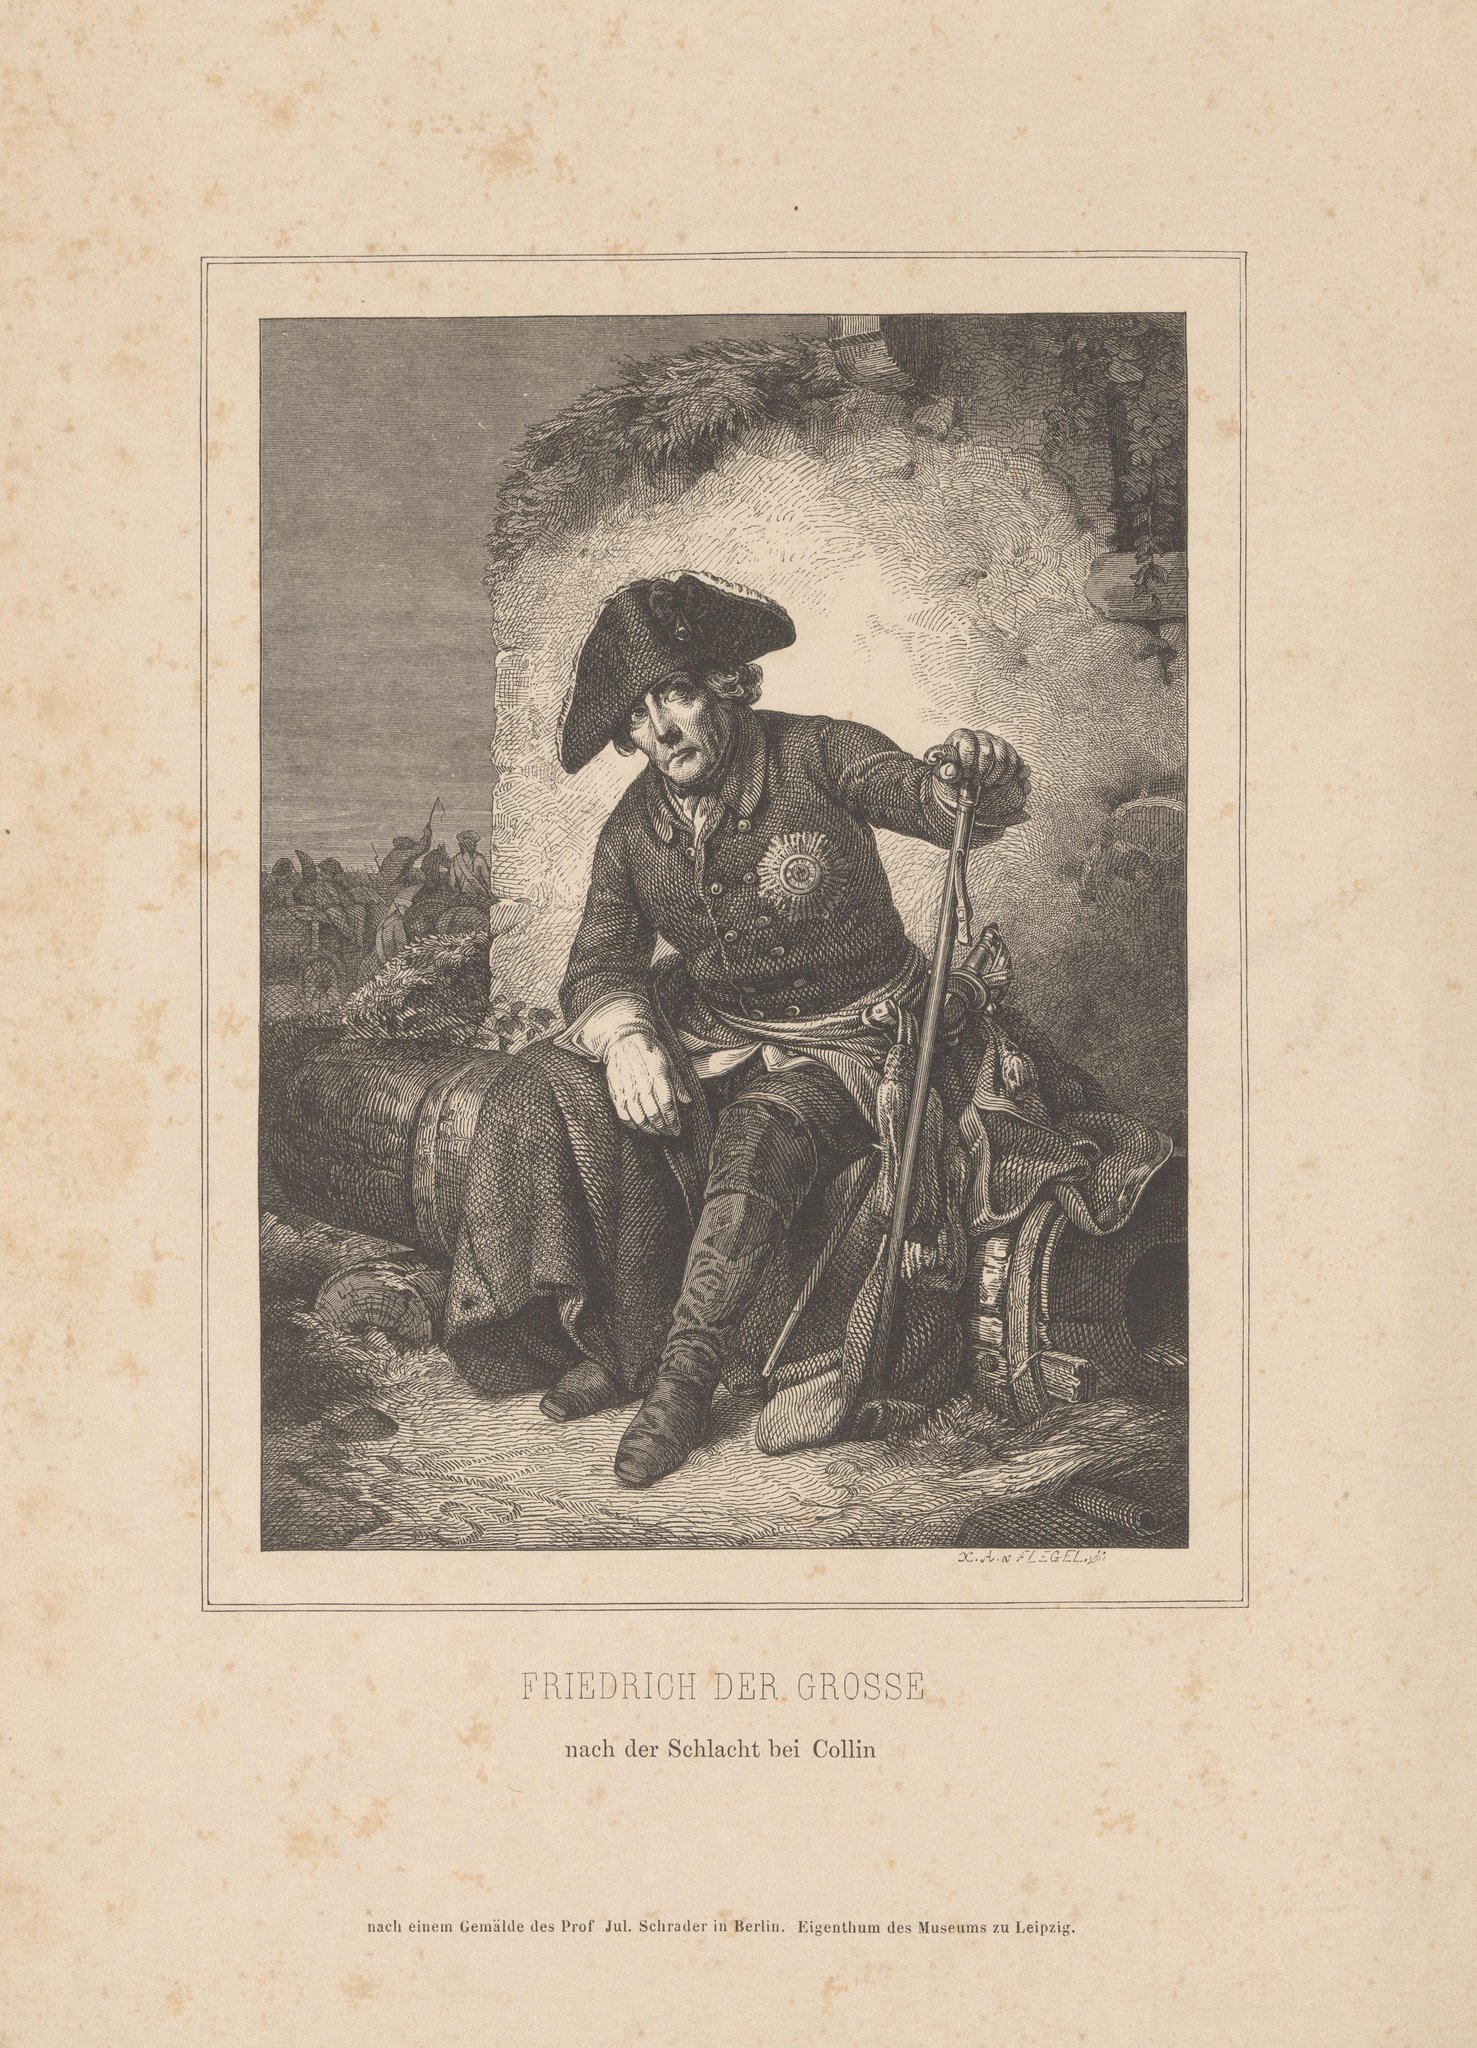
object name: print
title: Portret van Frederik de Grote na de slag bij Kolín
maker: johann gottfried flegel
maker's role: print maker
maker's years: 1815-1881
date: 1825-1881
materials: paper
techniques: engraving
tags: berlin, frederick ii (king of prussia), historical persons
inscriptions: collector's mark: Lugt 2228